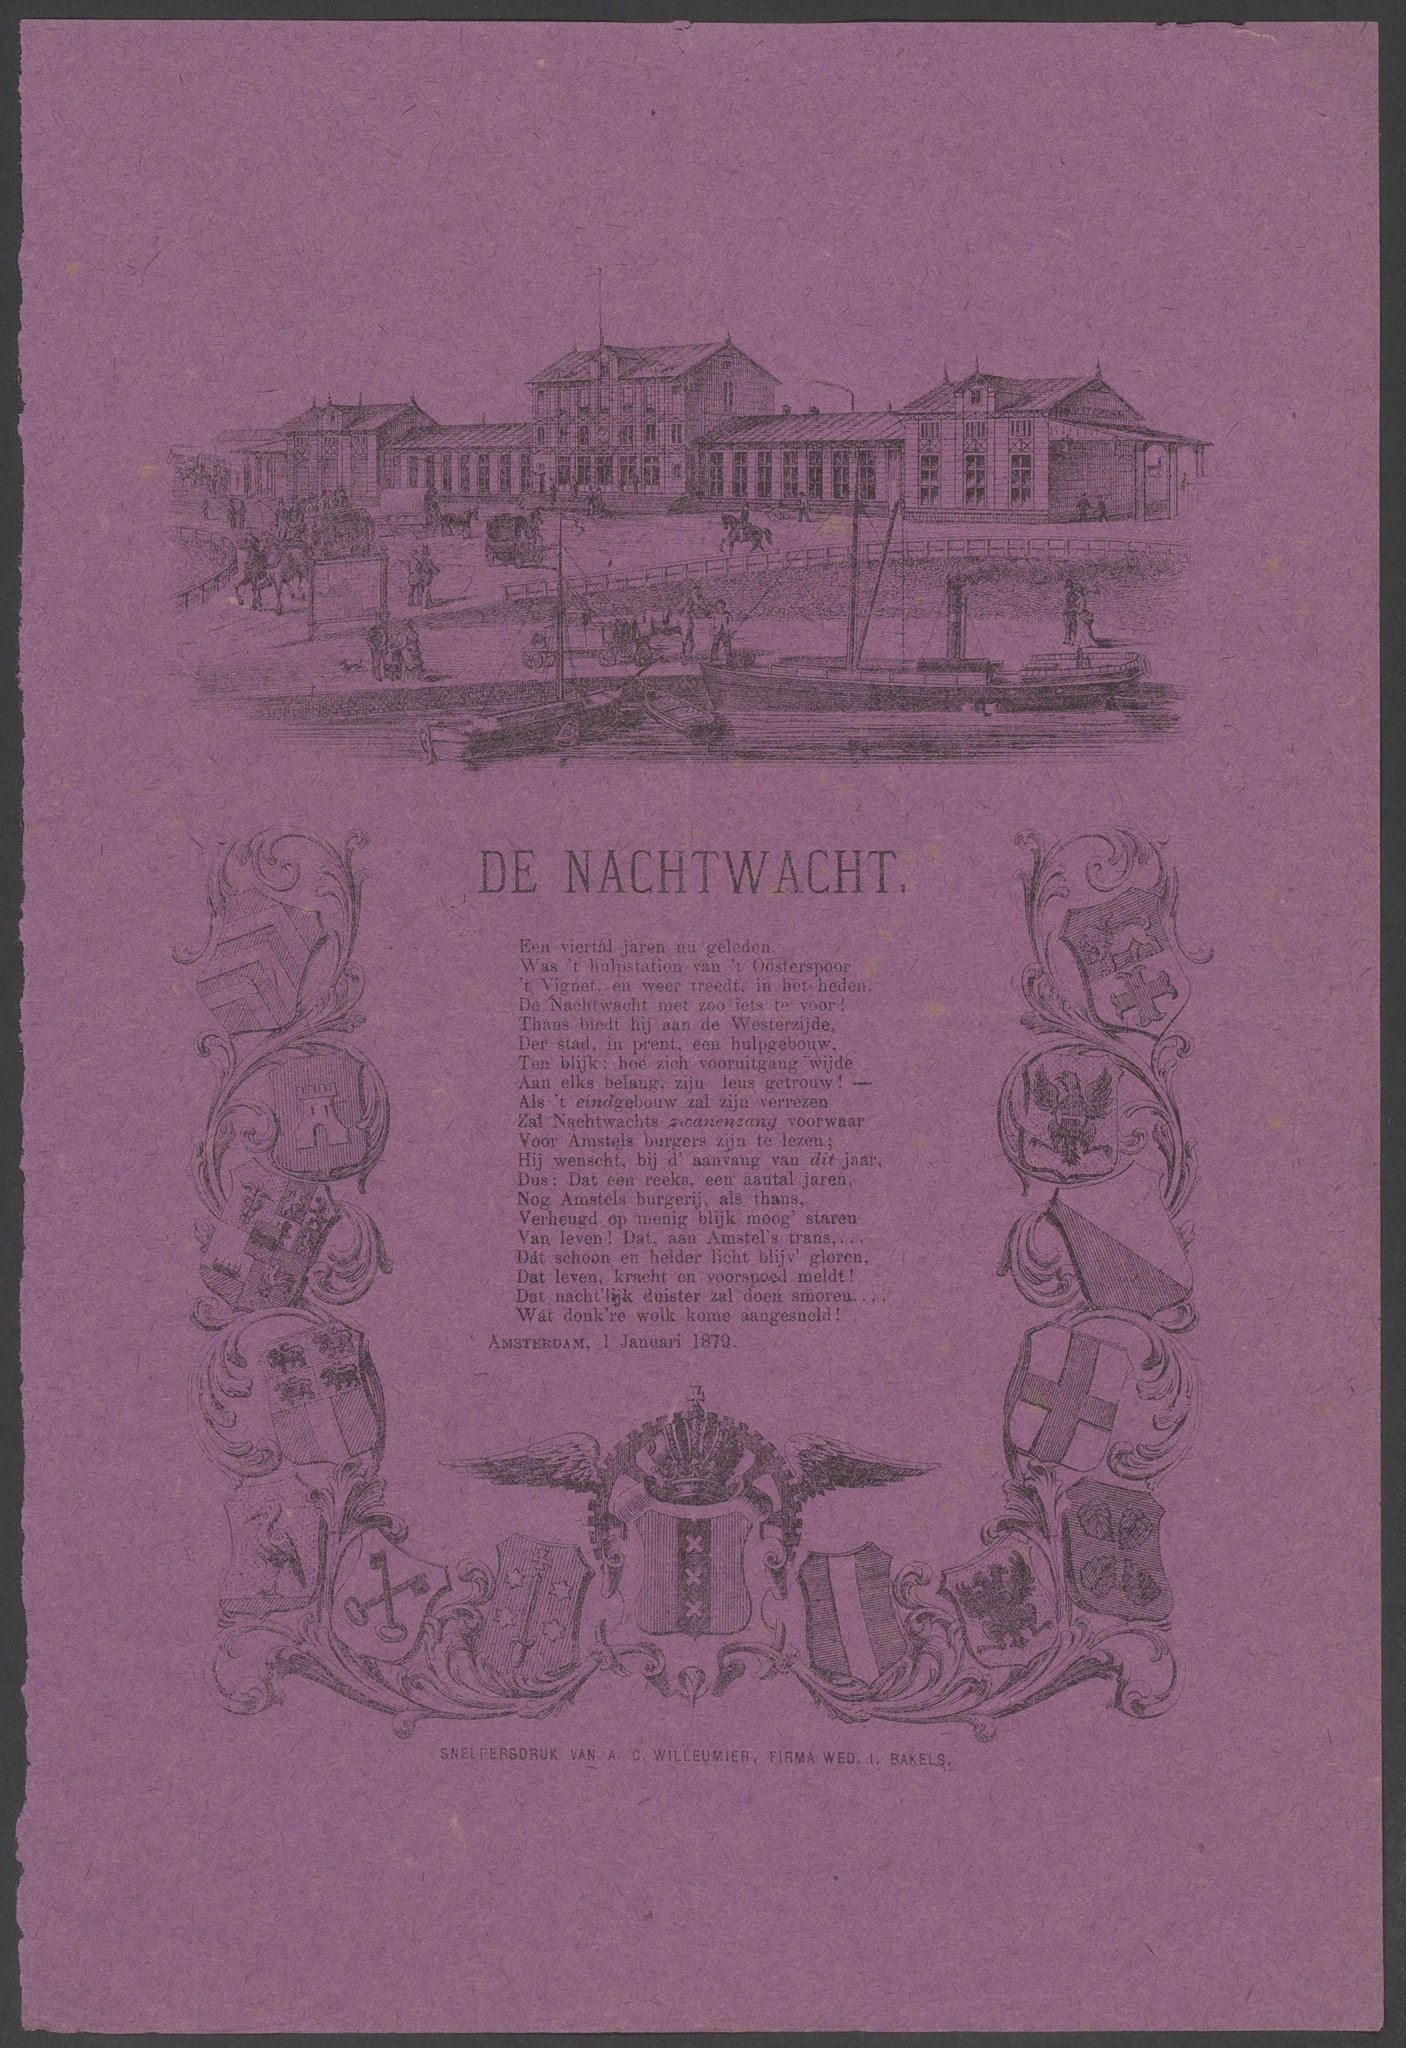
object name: new year card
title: De Nachtwacht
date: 1878-1879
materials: paper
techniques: lithograph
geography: amsterdam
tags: night patrol, station; shelter (railway, tramway), amsterdam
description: Nieuwjaarswens van de Amsterdamse nachtwacht (ratelwacht) voor het jaar 1879. Centraal een gedicht, bovenaan een gezicht op het hulpstation Westerdok van het Oosterspoor van de Hollandsche IJzeren Spoorweg-Maatschappij op de Droogbak. Om het gedicht wapenschilden. Onderwerpsrubrieken binnen de Atlas Zeden en Gewoonten: Zeden en gewoonten in engeren zin, Volksleven, Volksbladen, Nieuwjaars- en Kerstwenschen, Amsterdam.